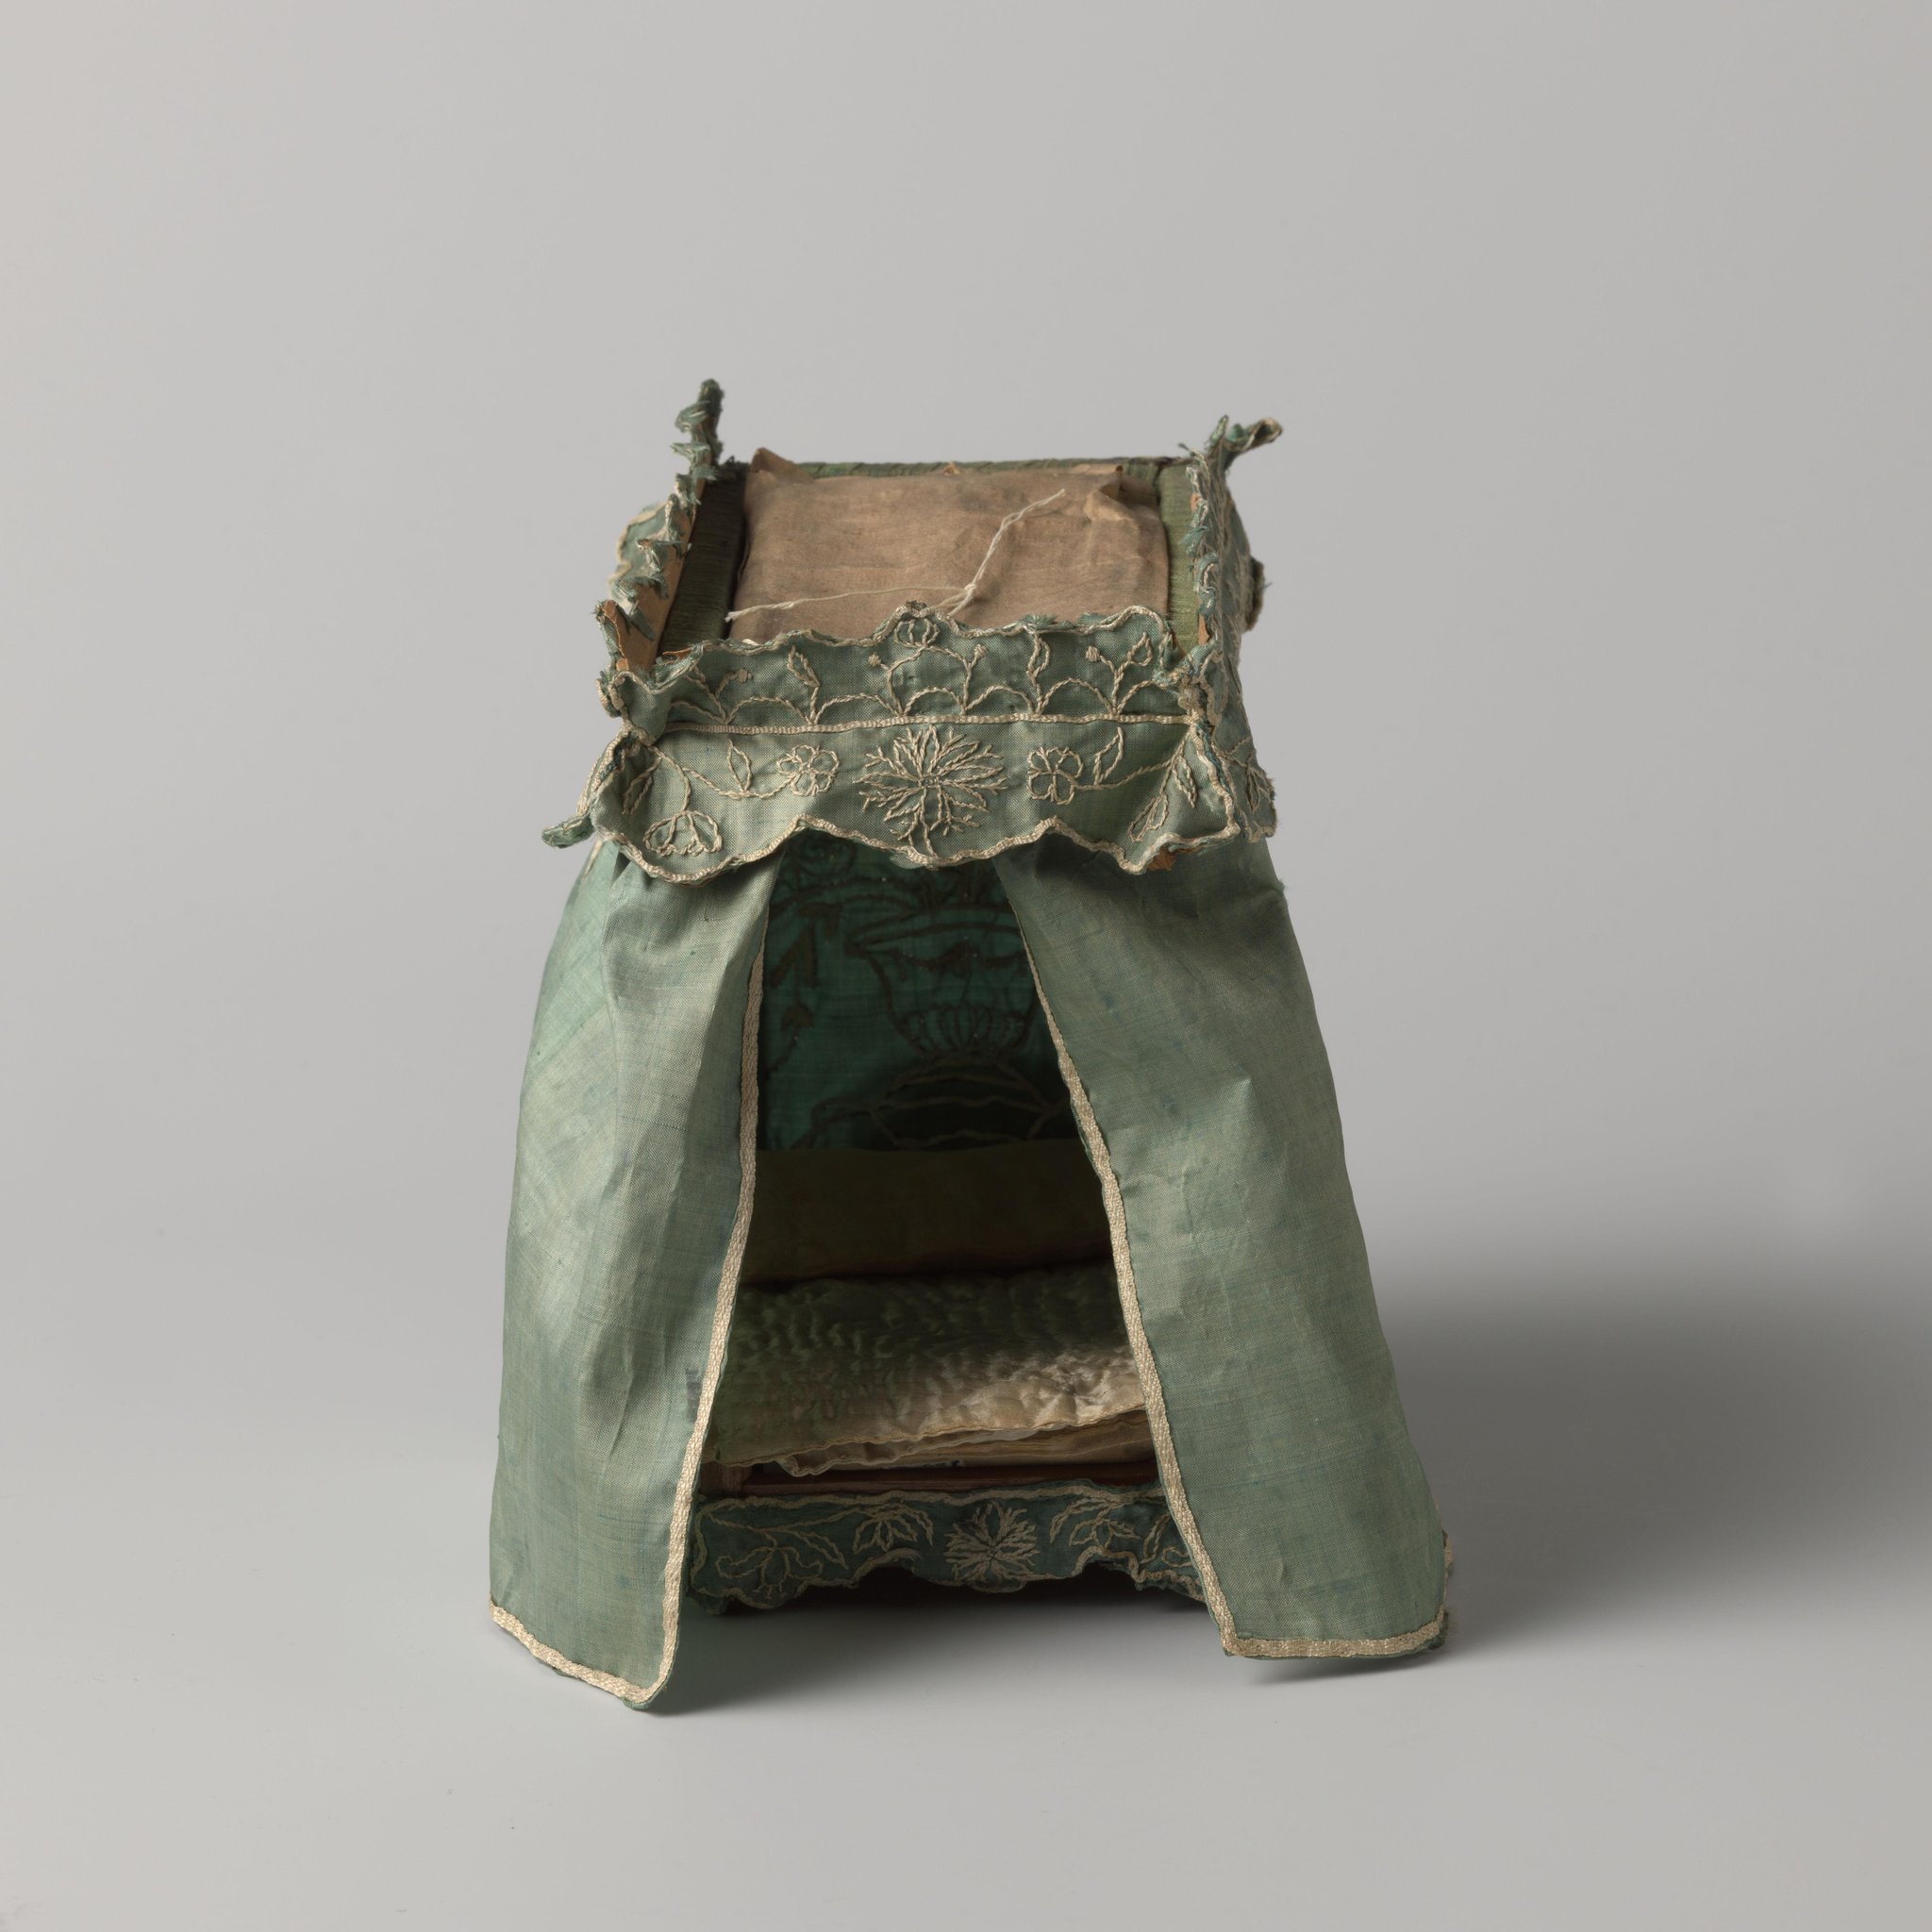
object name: cushion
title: Hemelbed met kussen en matras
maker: Anonymous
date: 1749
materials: copper, linen, wood, paper, silk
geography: haarlem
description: Hemelbed van het type lit d'Ange van mahoniehout. Het bed is behangen met zacht blauwgroene zijden gordijnen en met vallen, geappliqeerd met wit zijden band en garen. Op het bed ligt een matras en een kussen.